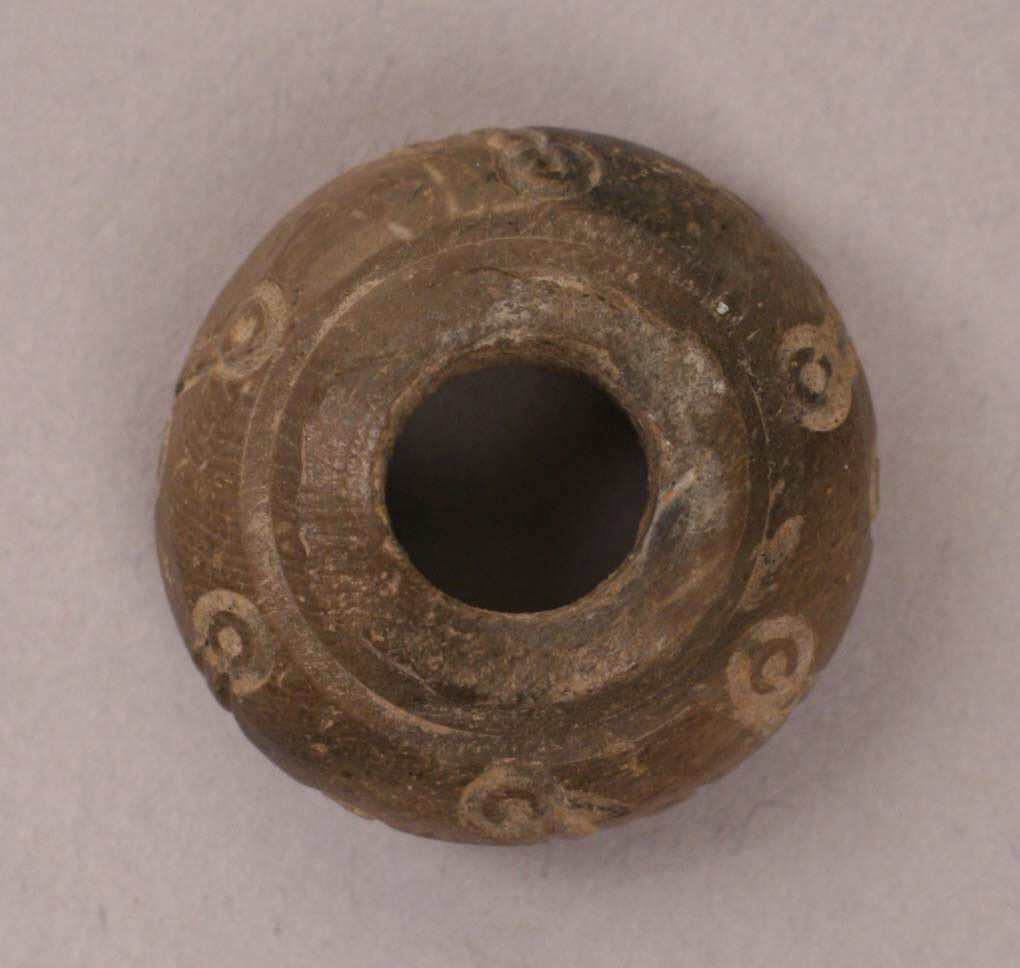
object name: button or bead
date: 801-1000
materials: bone, paint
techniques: incising, inlay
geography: iran